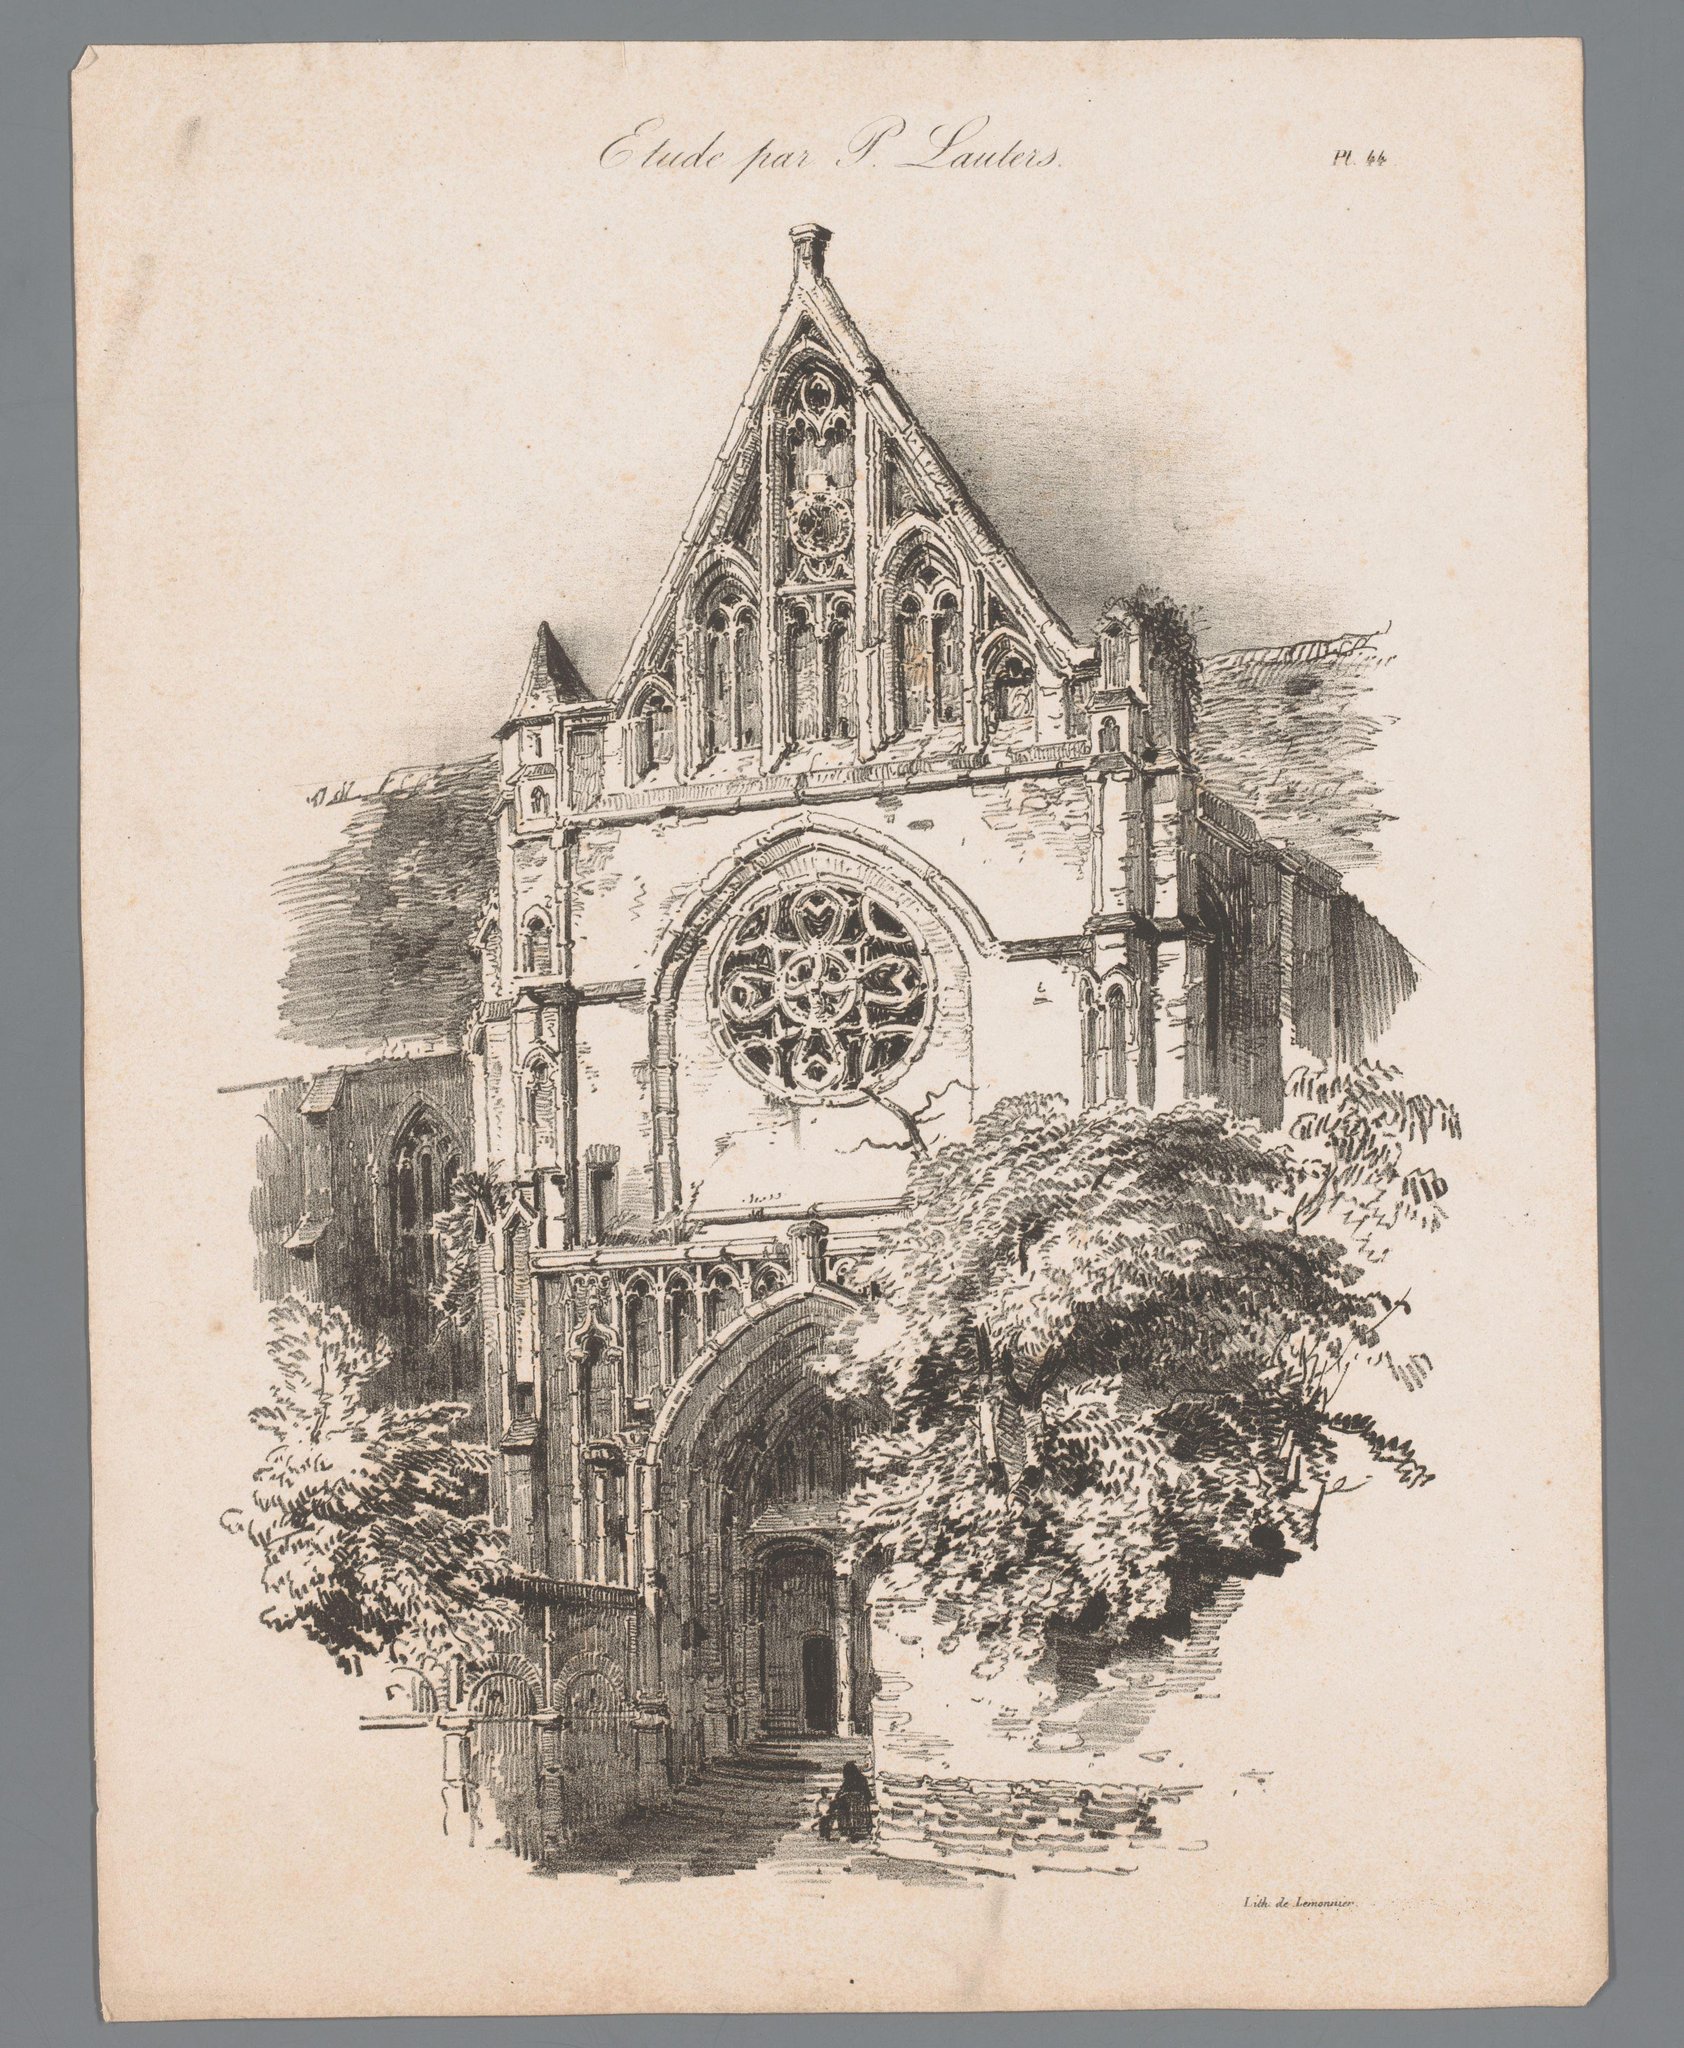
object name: print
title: Etude par P. Lauters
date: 1816-1875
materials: paper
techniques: lithograph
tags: parts of church exterior and annexes: portal, church-window, e.g. rose-window, church (exterior)